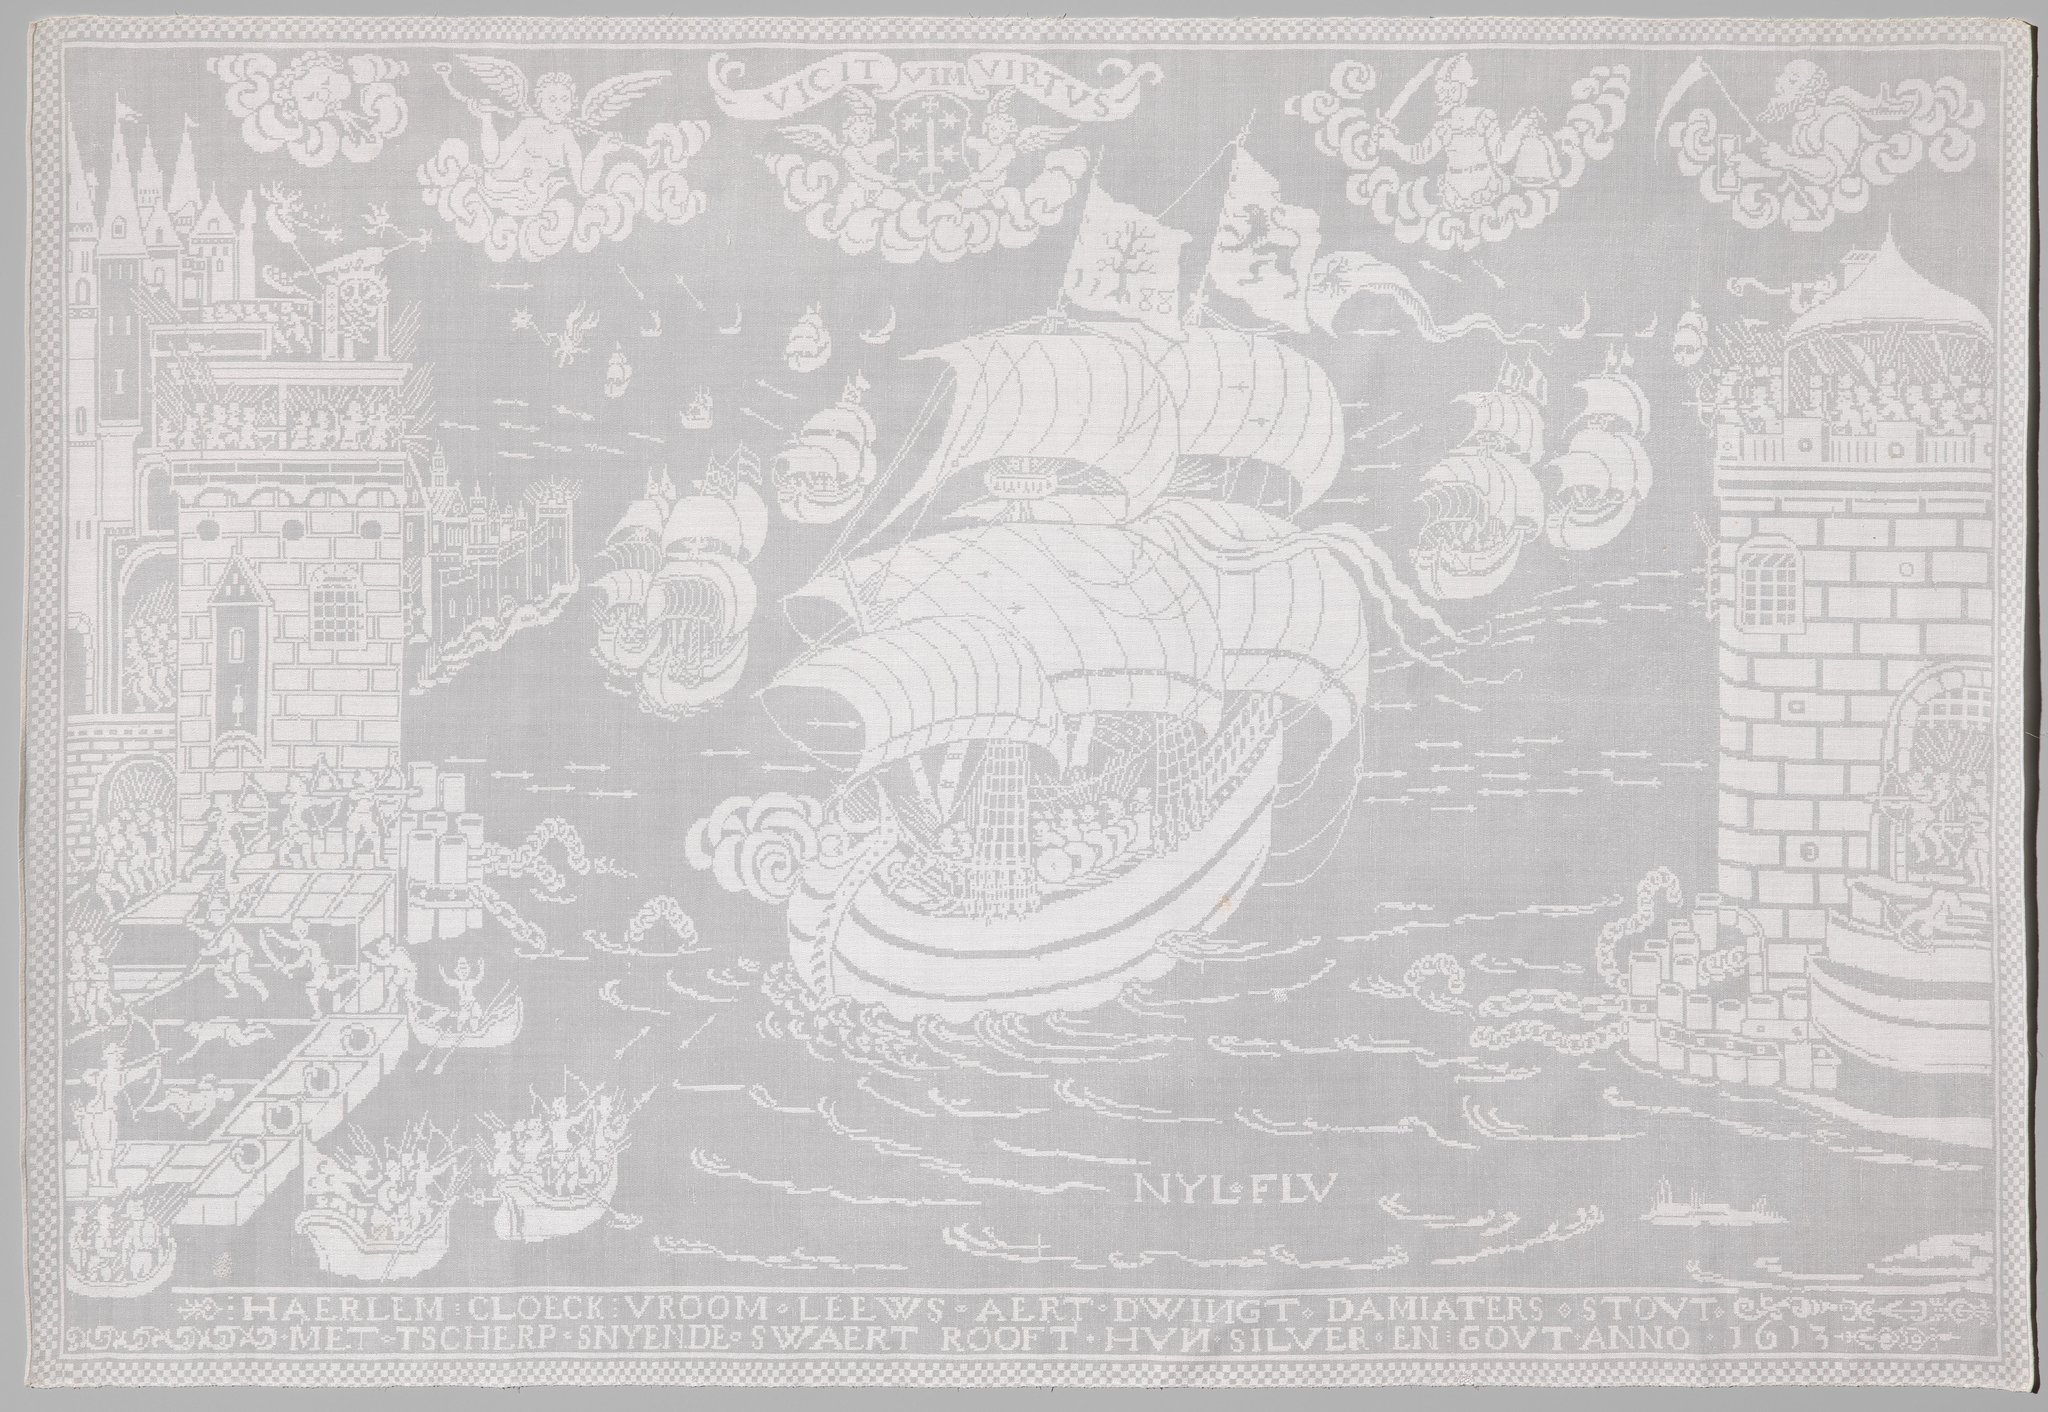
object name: napkin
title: Verovering van Damiate door de Haarlemmers in 1188.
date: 1613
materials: linen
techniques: damask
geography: haarlem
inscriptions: date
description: Wit linnen damasten servet met de verovering van Damiate door de Haarlemmers in 1188. Met wapenspreuk VICIT VIM VIRTVS en opschrift NYL FLV. Onderschrift: HAERLEM CLOECK VROOM LEEWS AERT DWINGT DAMIATERS STOVT/MET TSCHERP SNYENDE SWAERT ROOFT HVN SILVER EN GOVT.